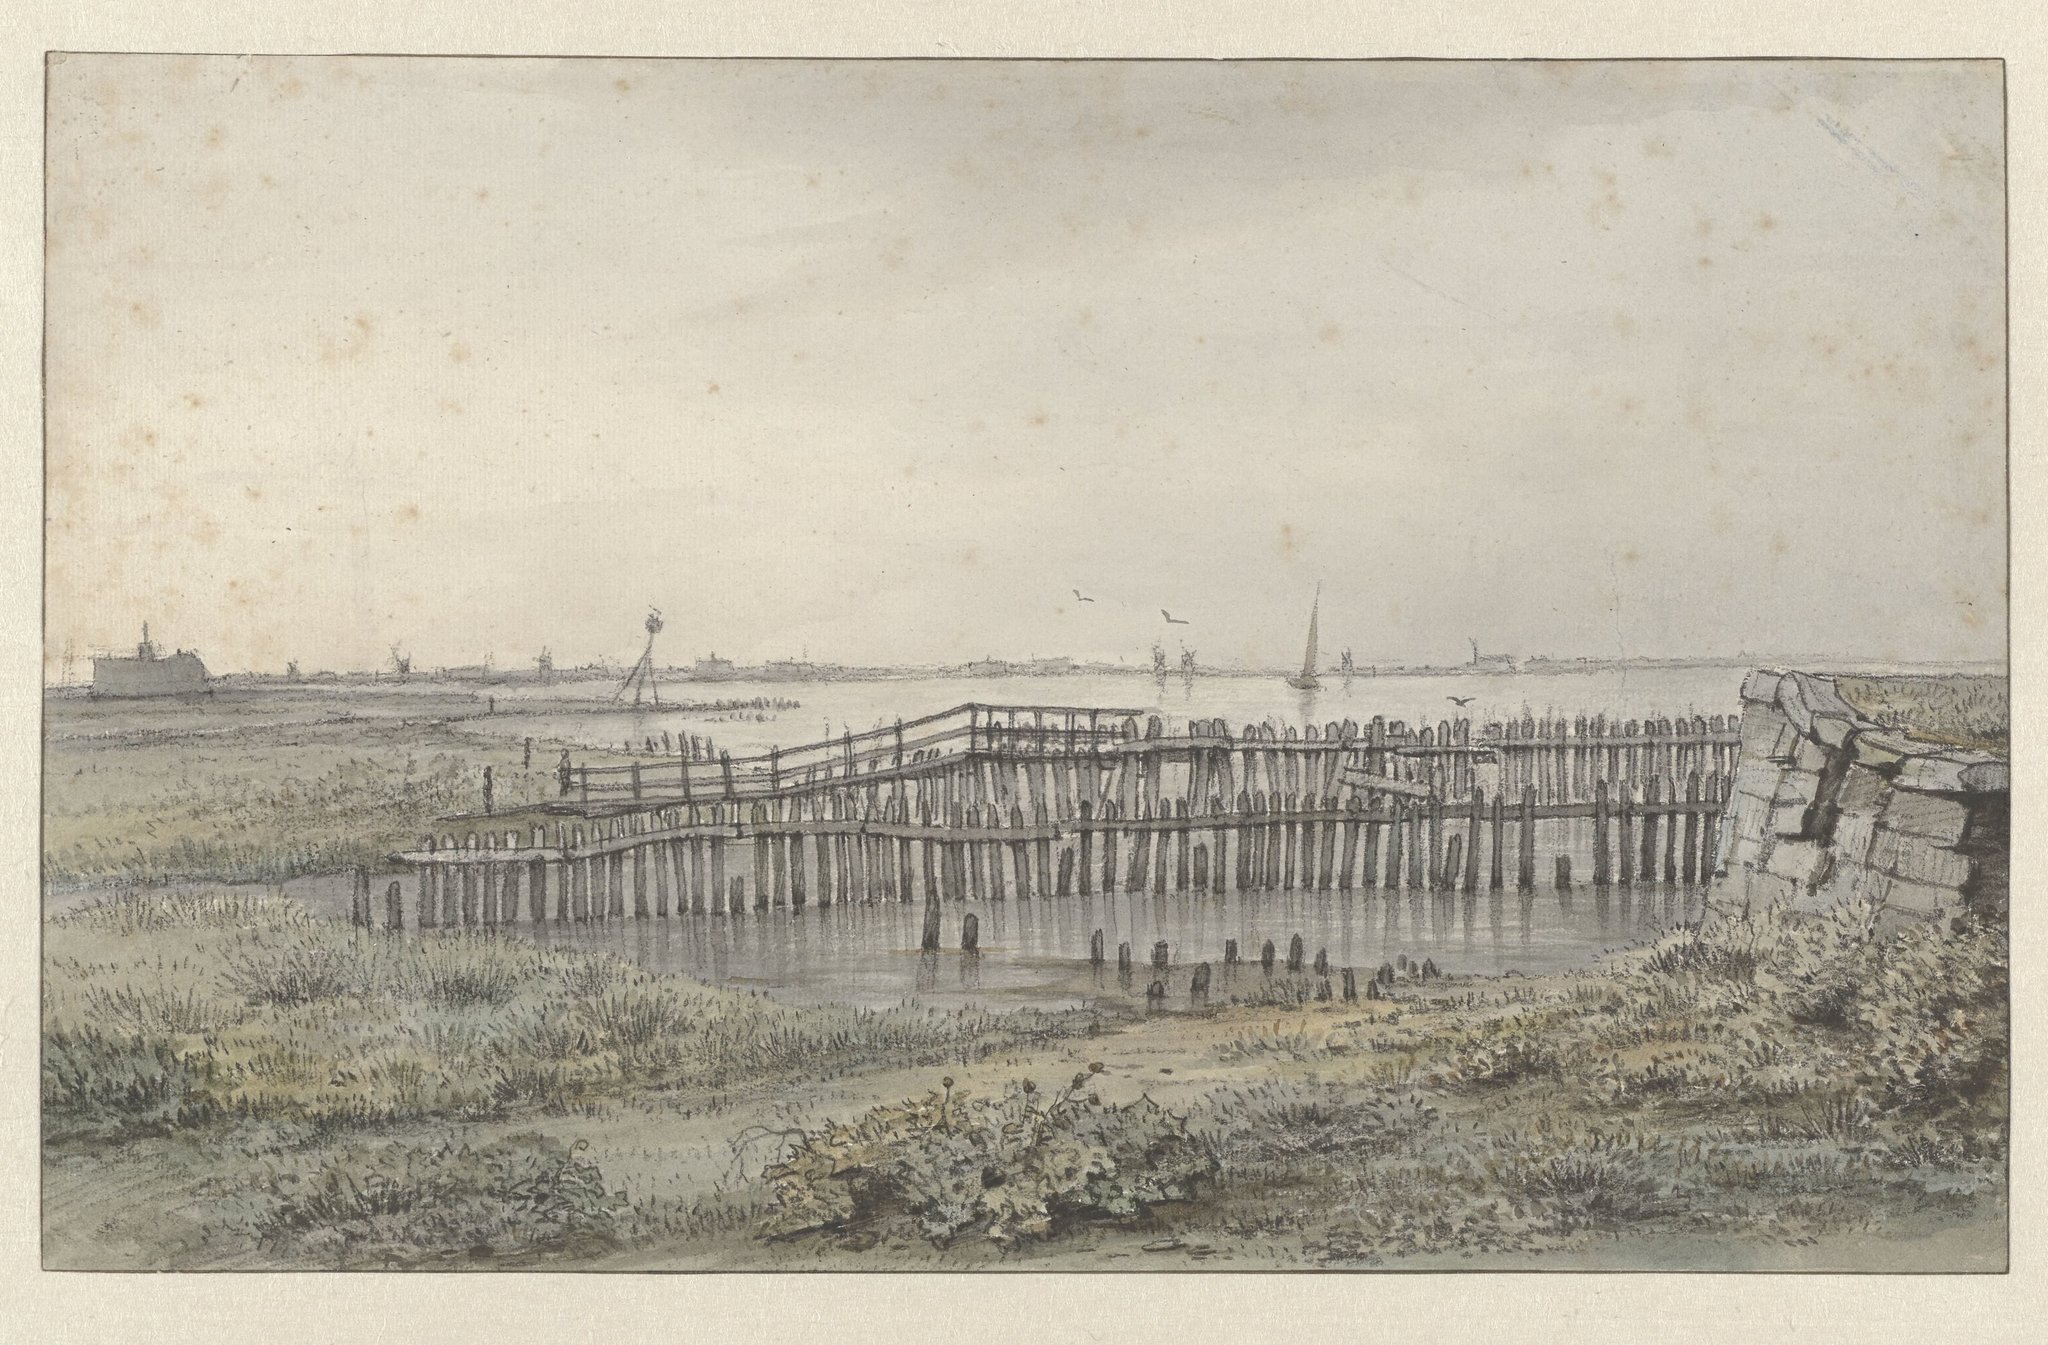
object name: watercolor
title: Rivierlandschap met palissaden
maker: joannes dijkhoff jr.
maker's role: draughtsman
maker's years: 1795-1862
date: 1805-1862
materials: chalk, paper, watercolor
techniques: brush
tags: river